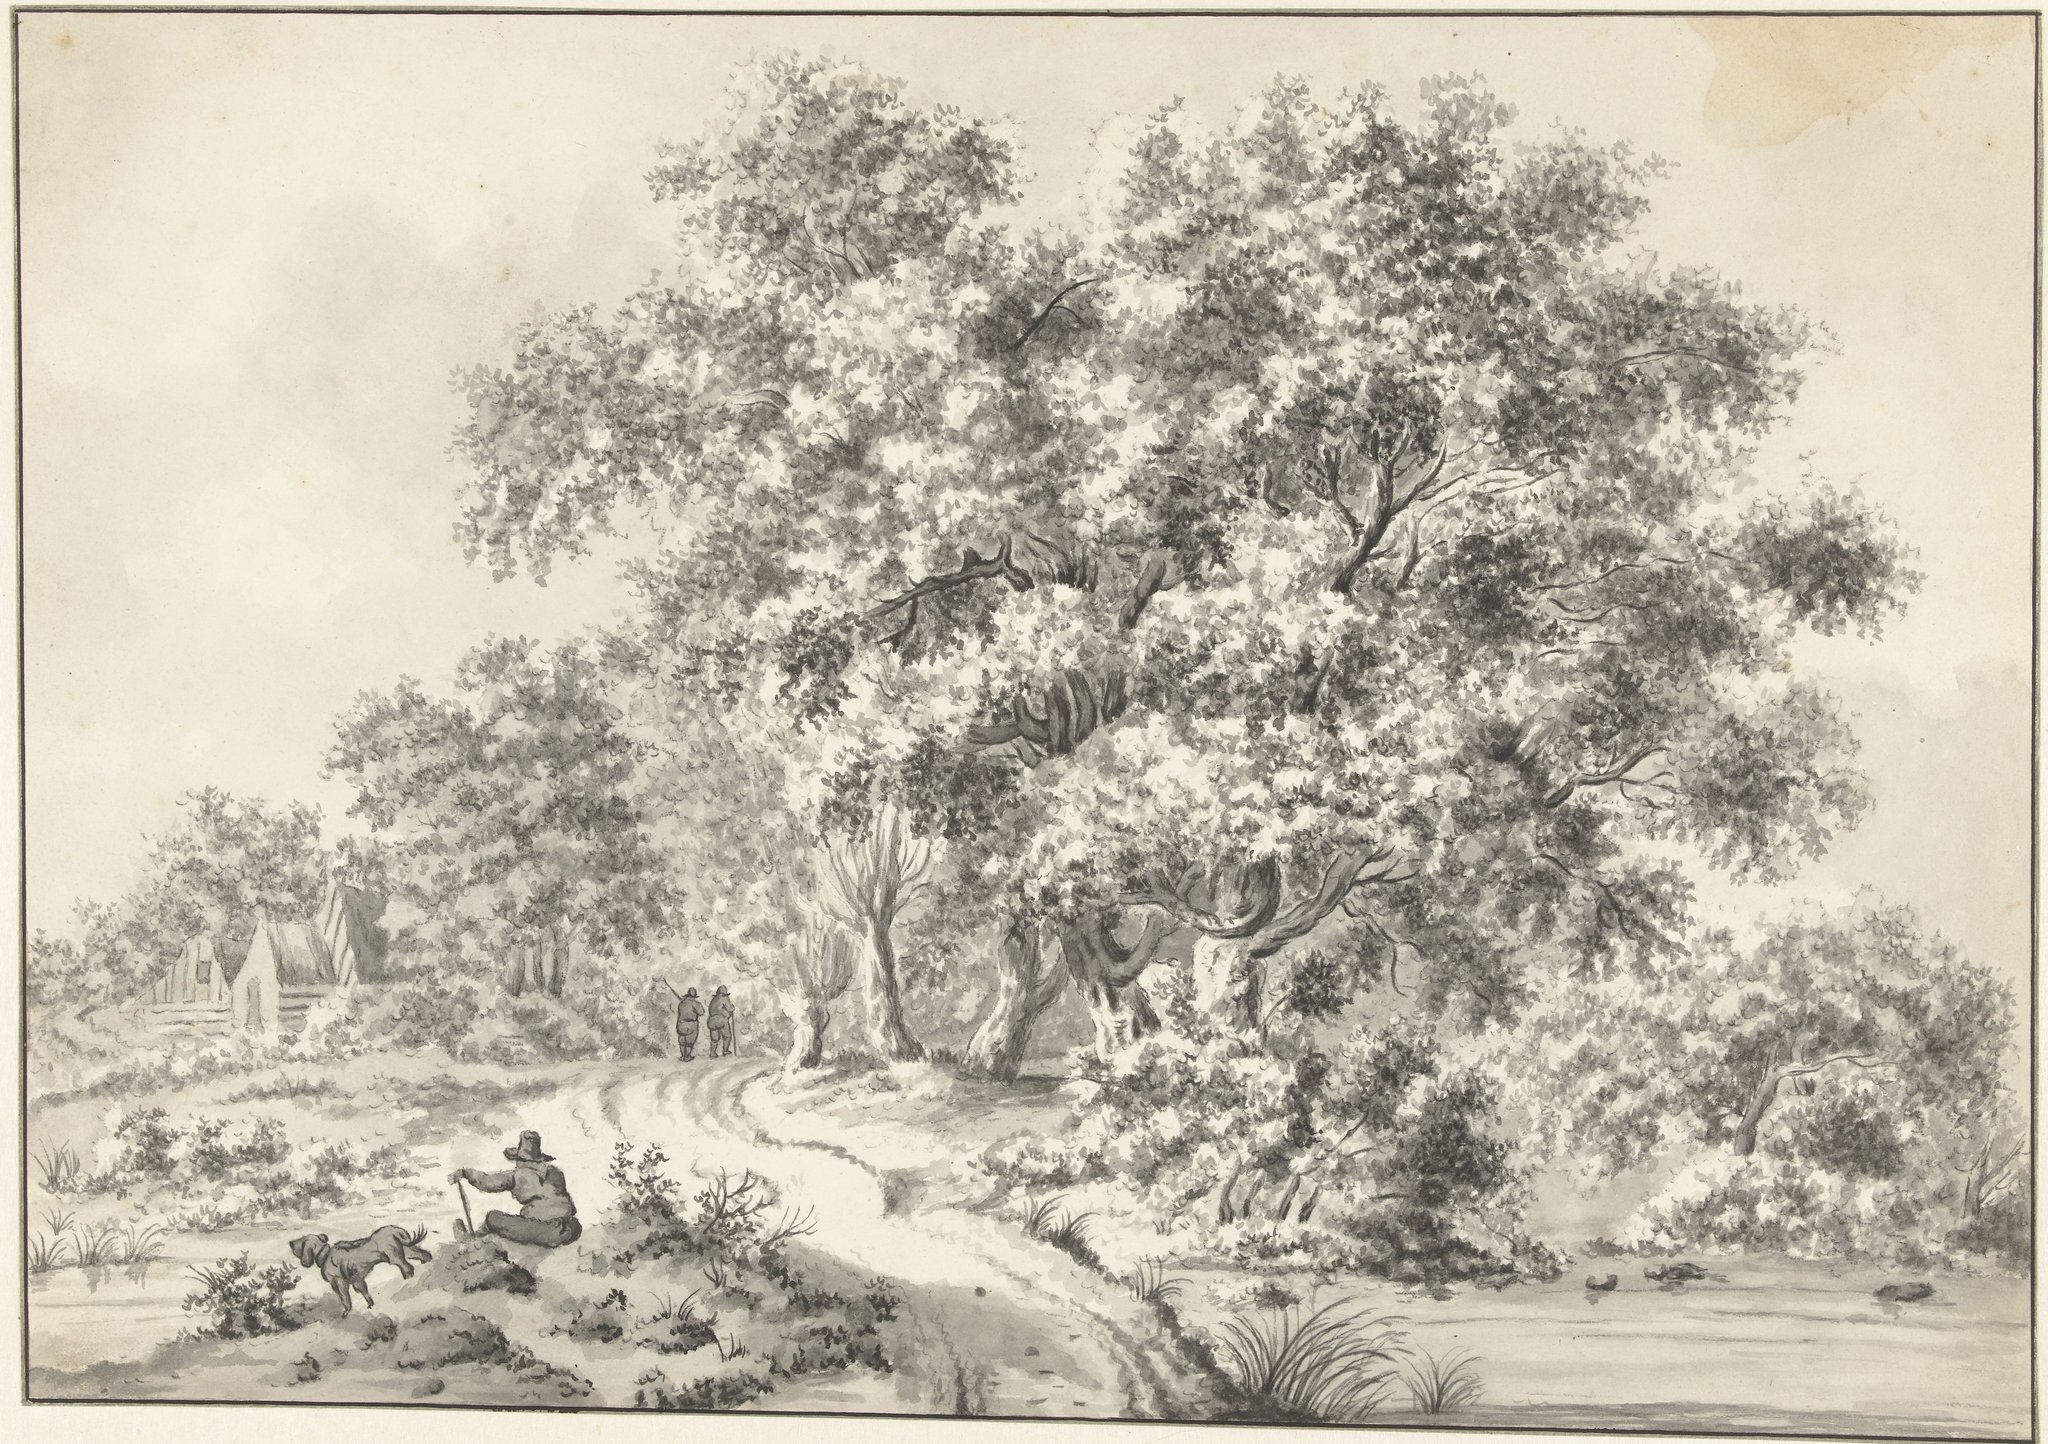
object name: drawing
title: Landschap met zittende man met hond en wandelaars op landweg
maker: jurriaan andriessen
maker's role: draughtsman, painter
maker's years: 1742-1819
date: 1752-1819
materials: chalk, ink, paper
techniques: brush, pen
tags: dog